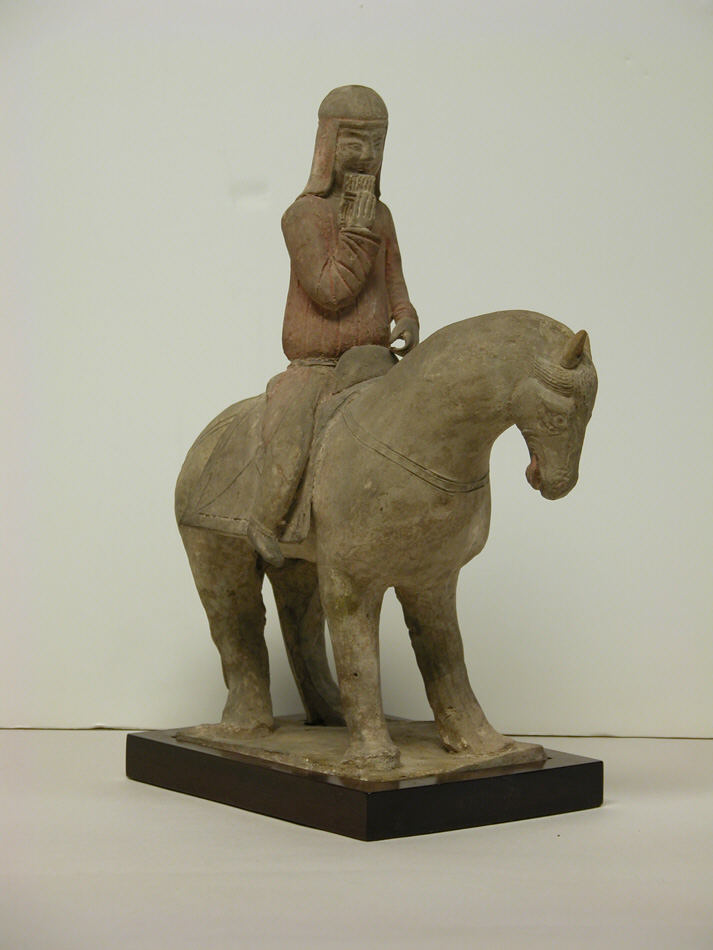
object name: figure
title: Mounted musician (one of two)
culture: chinese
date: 401-500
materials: earthenware, pigment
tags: horses